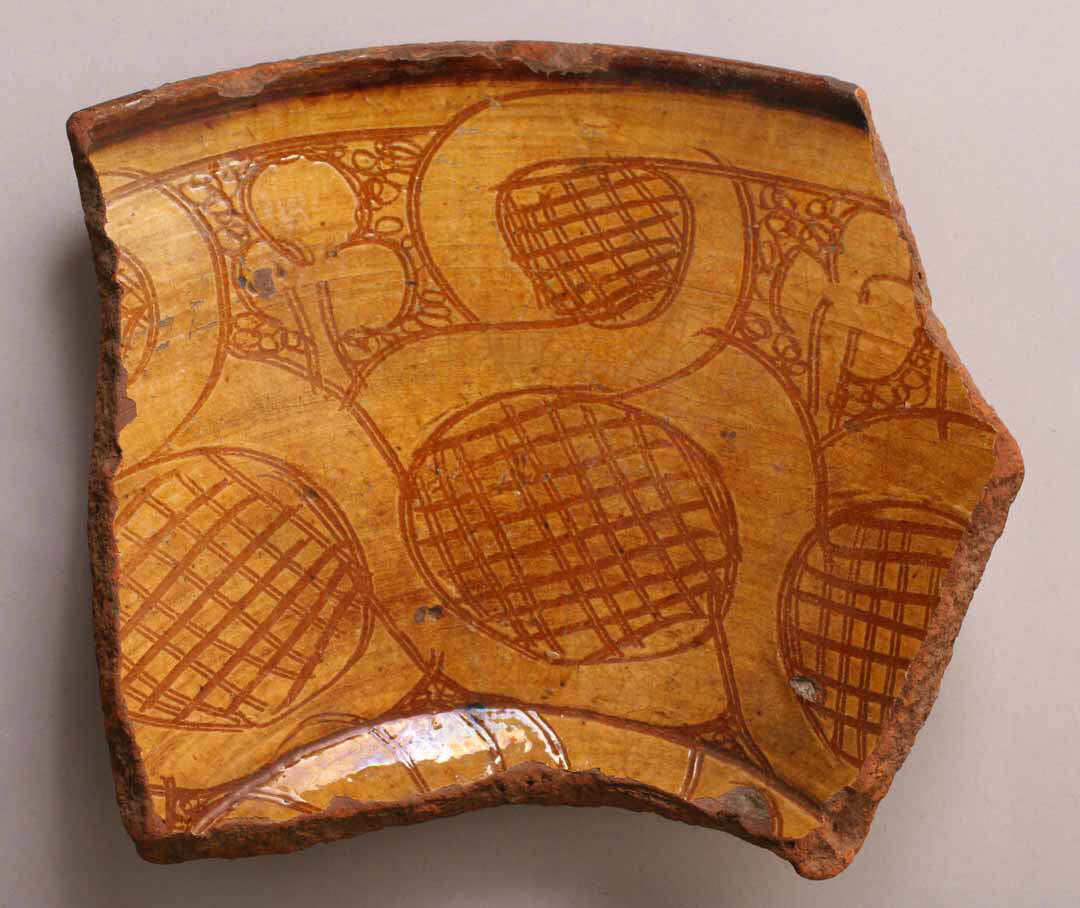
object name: ceramic fragment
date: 1301-1500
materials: earthenware, glaze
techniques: coloring, incising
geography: egypt